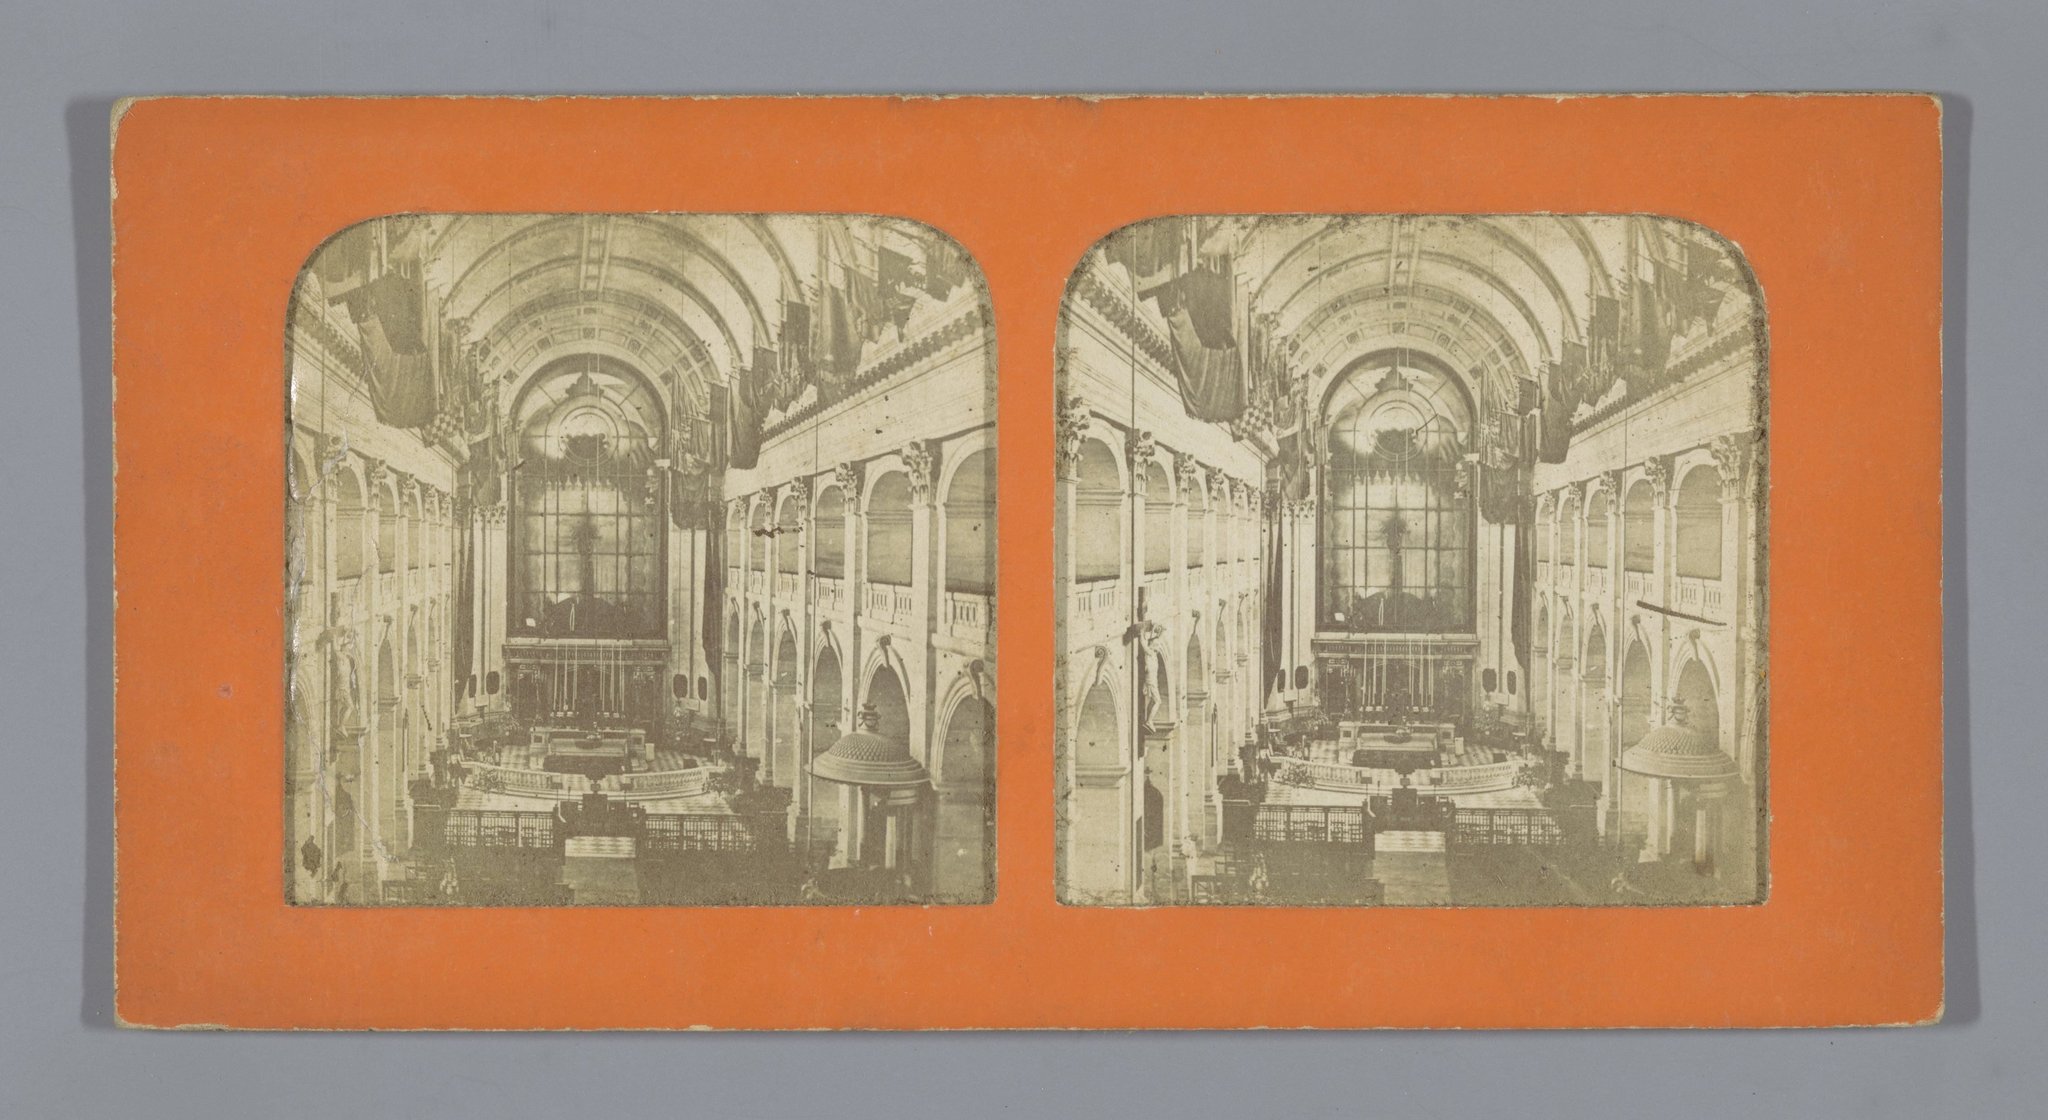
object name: tissue stereograph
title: Paris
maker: Anonymous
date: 1855-1875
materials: cardboard, paper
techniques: albumen print, hand coloring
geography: paris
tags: parts of church interior: chapel